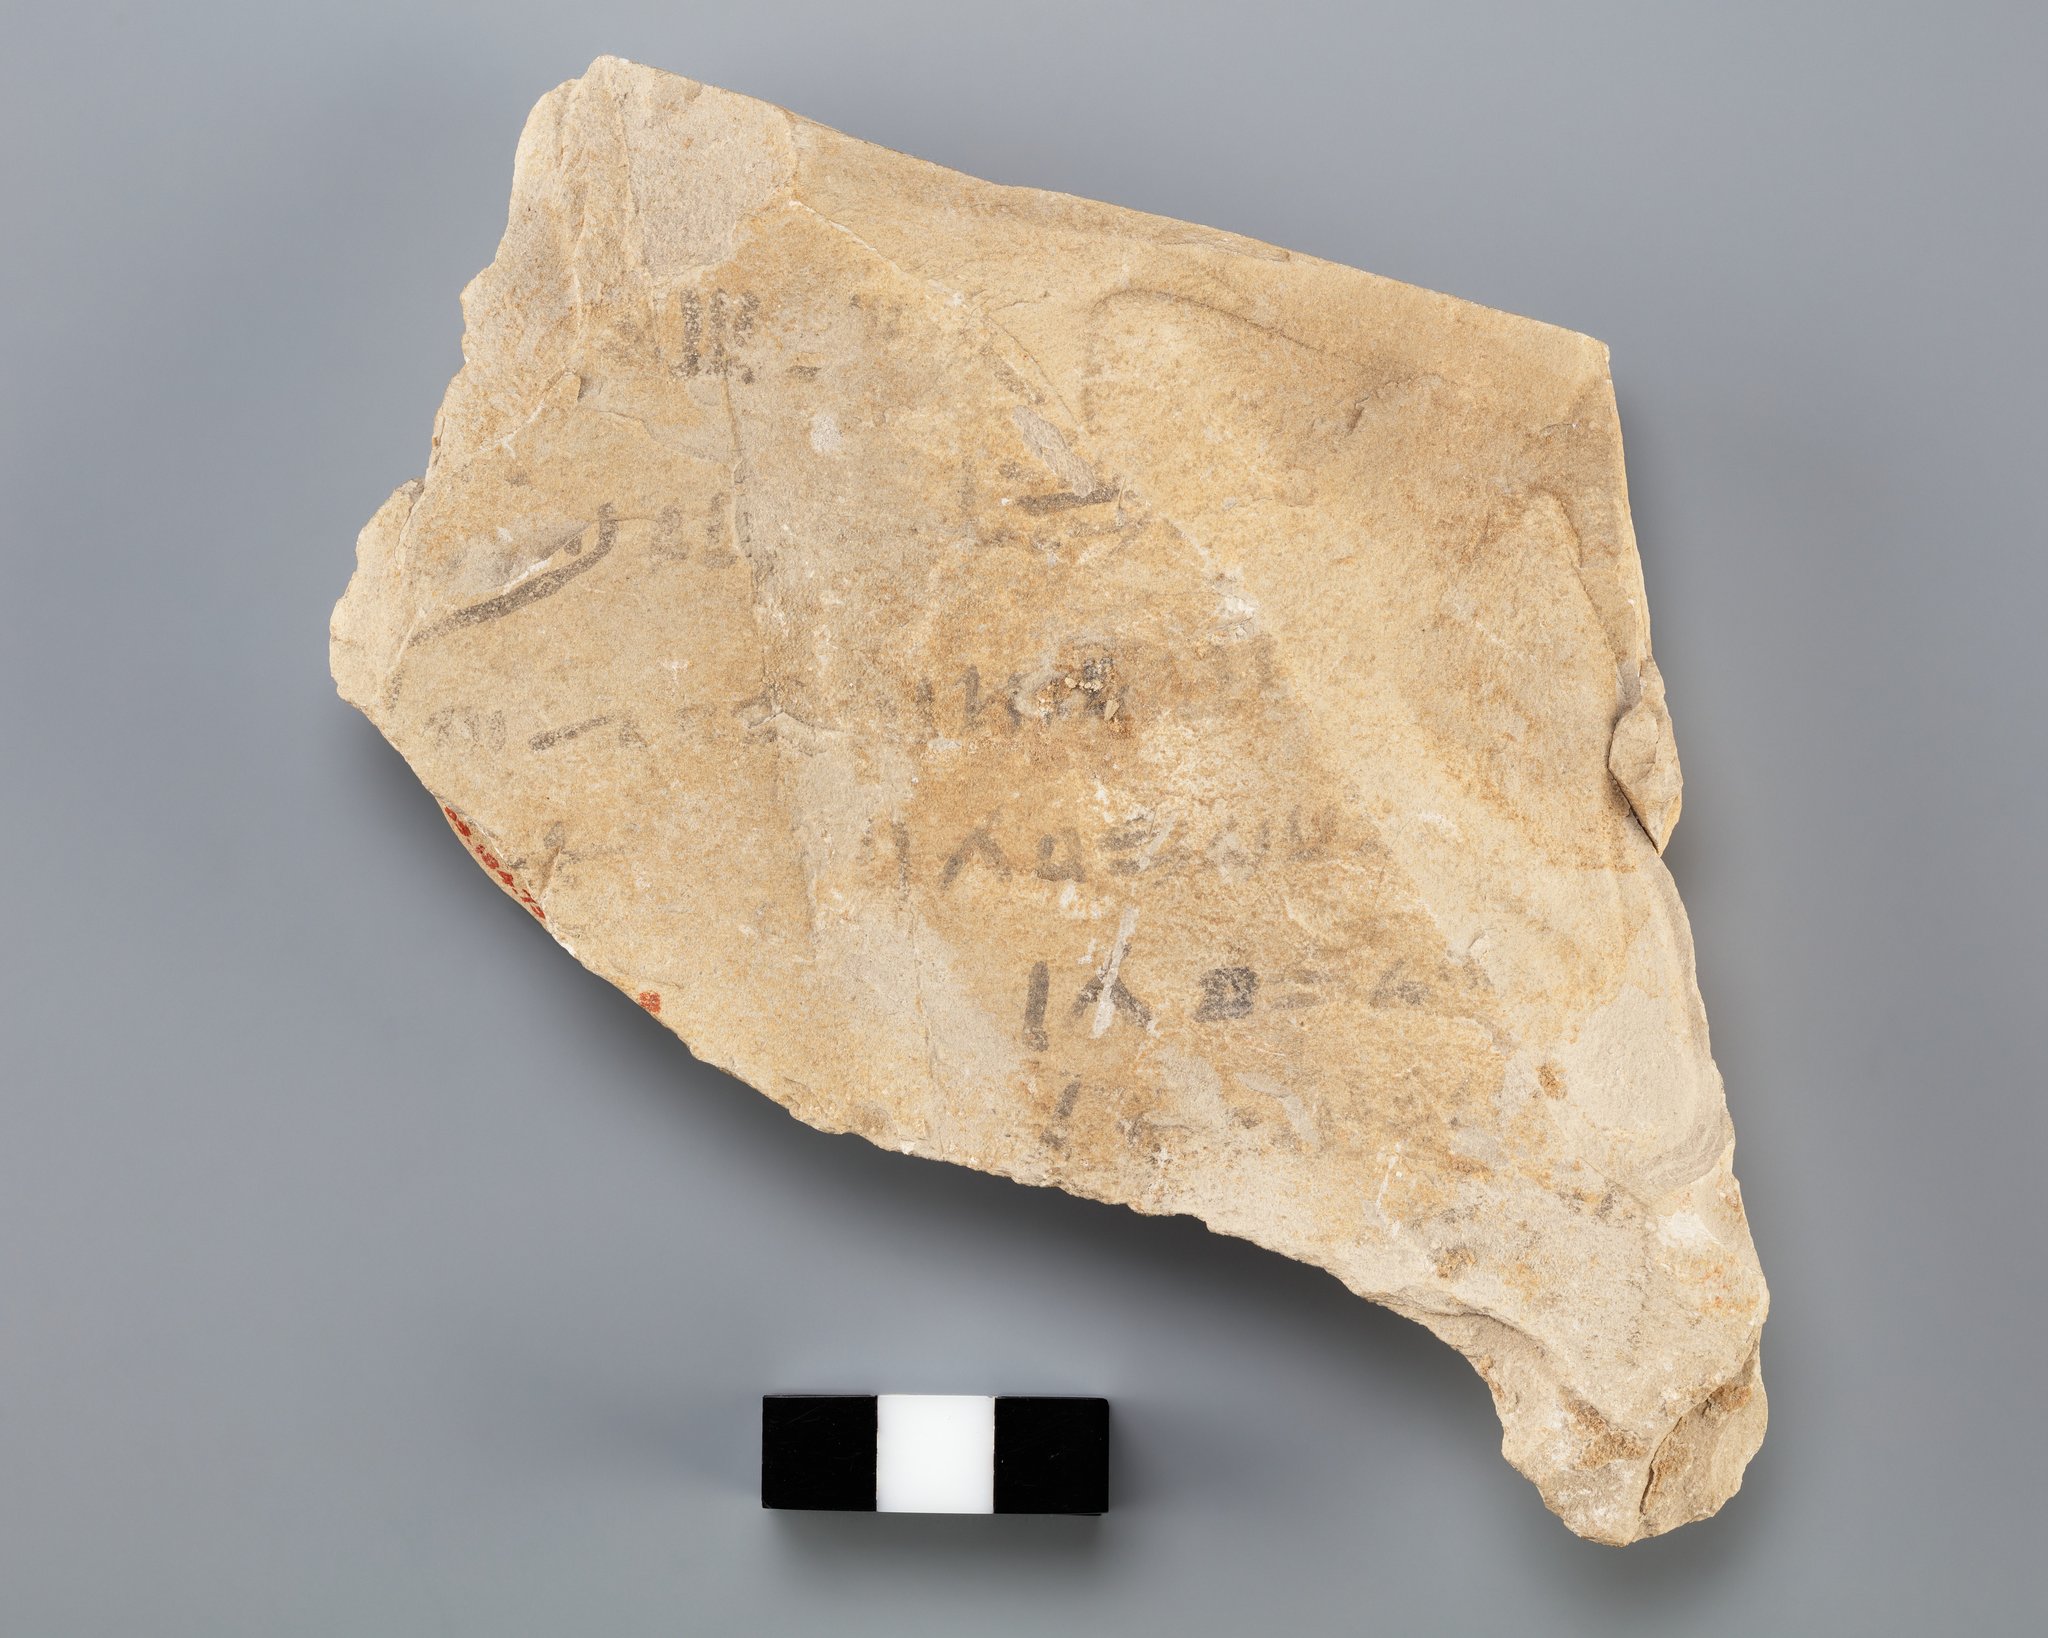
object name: ostracon, hieratic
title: Hieratic ostracon with account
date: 1295-1070 BCE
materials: ink, limestone, paint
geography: egypt